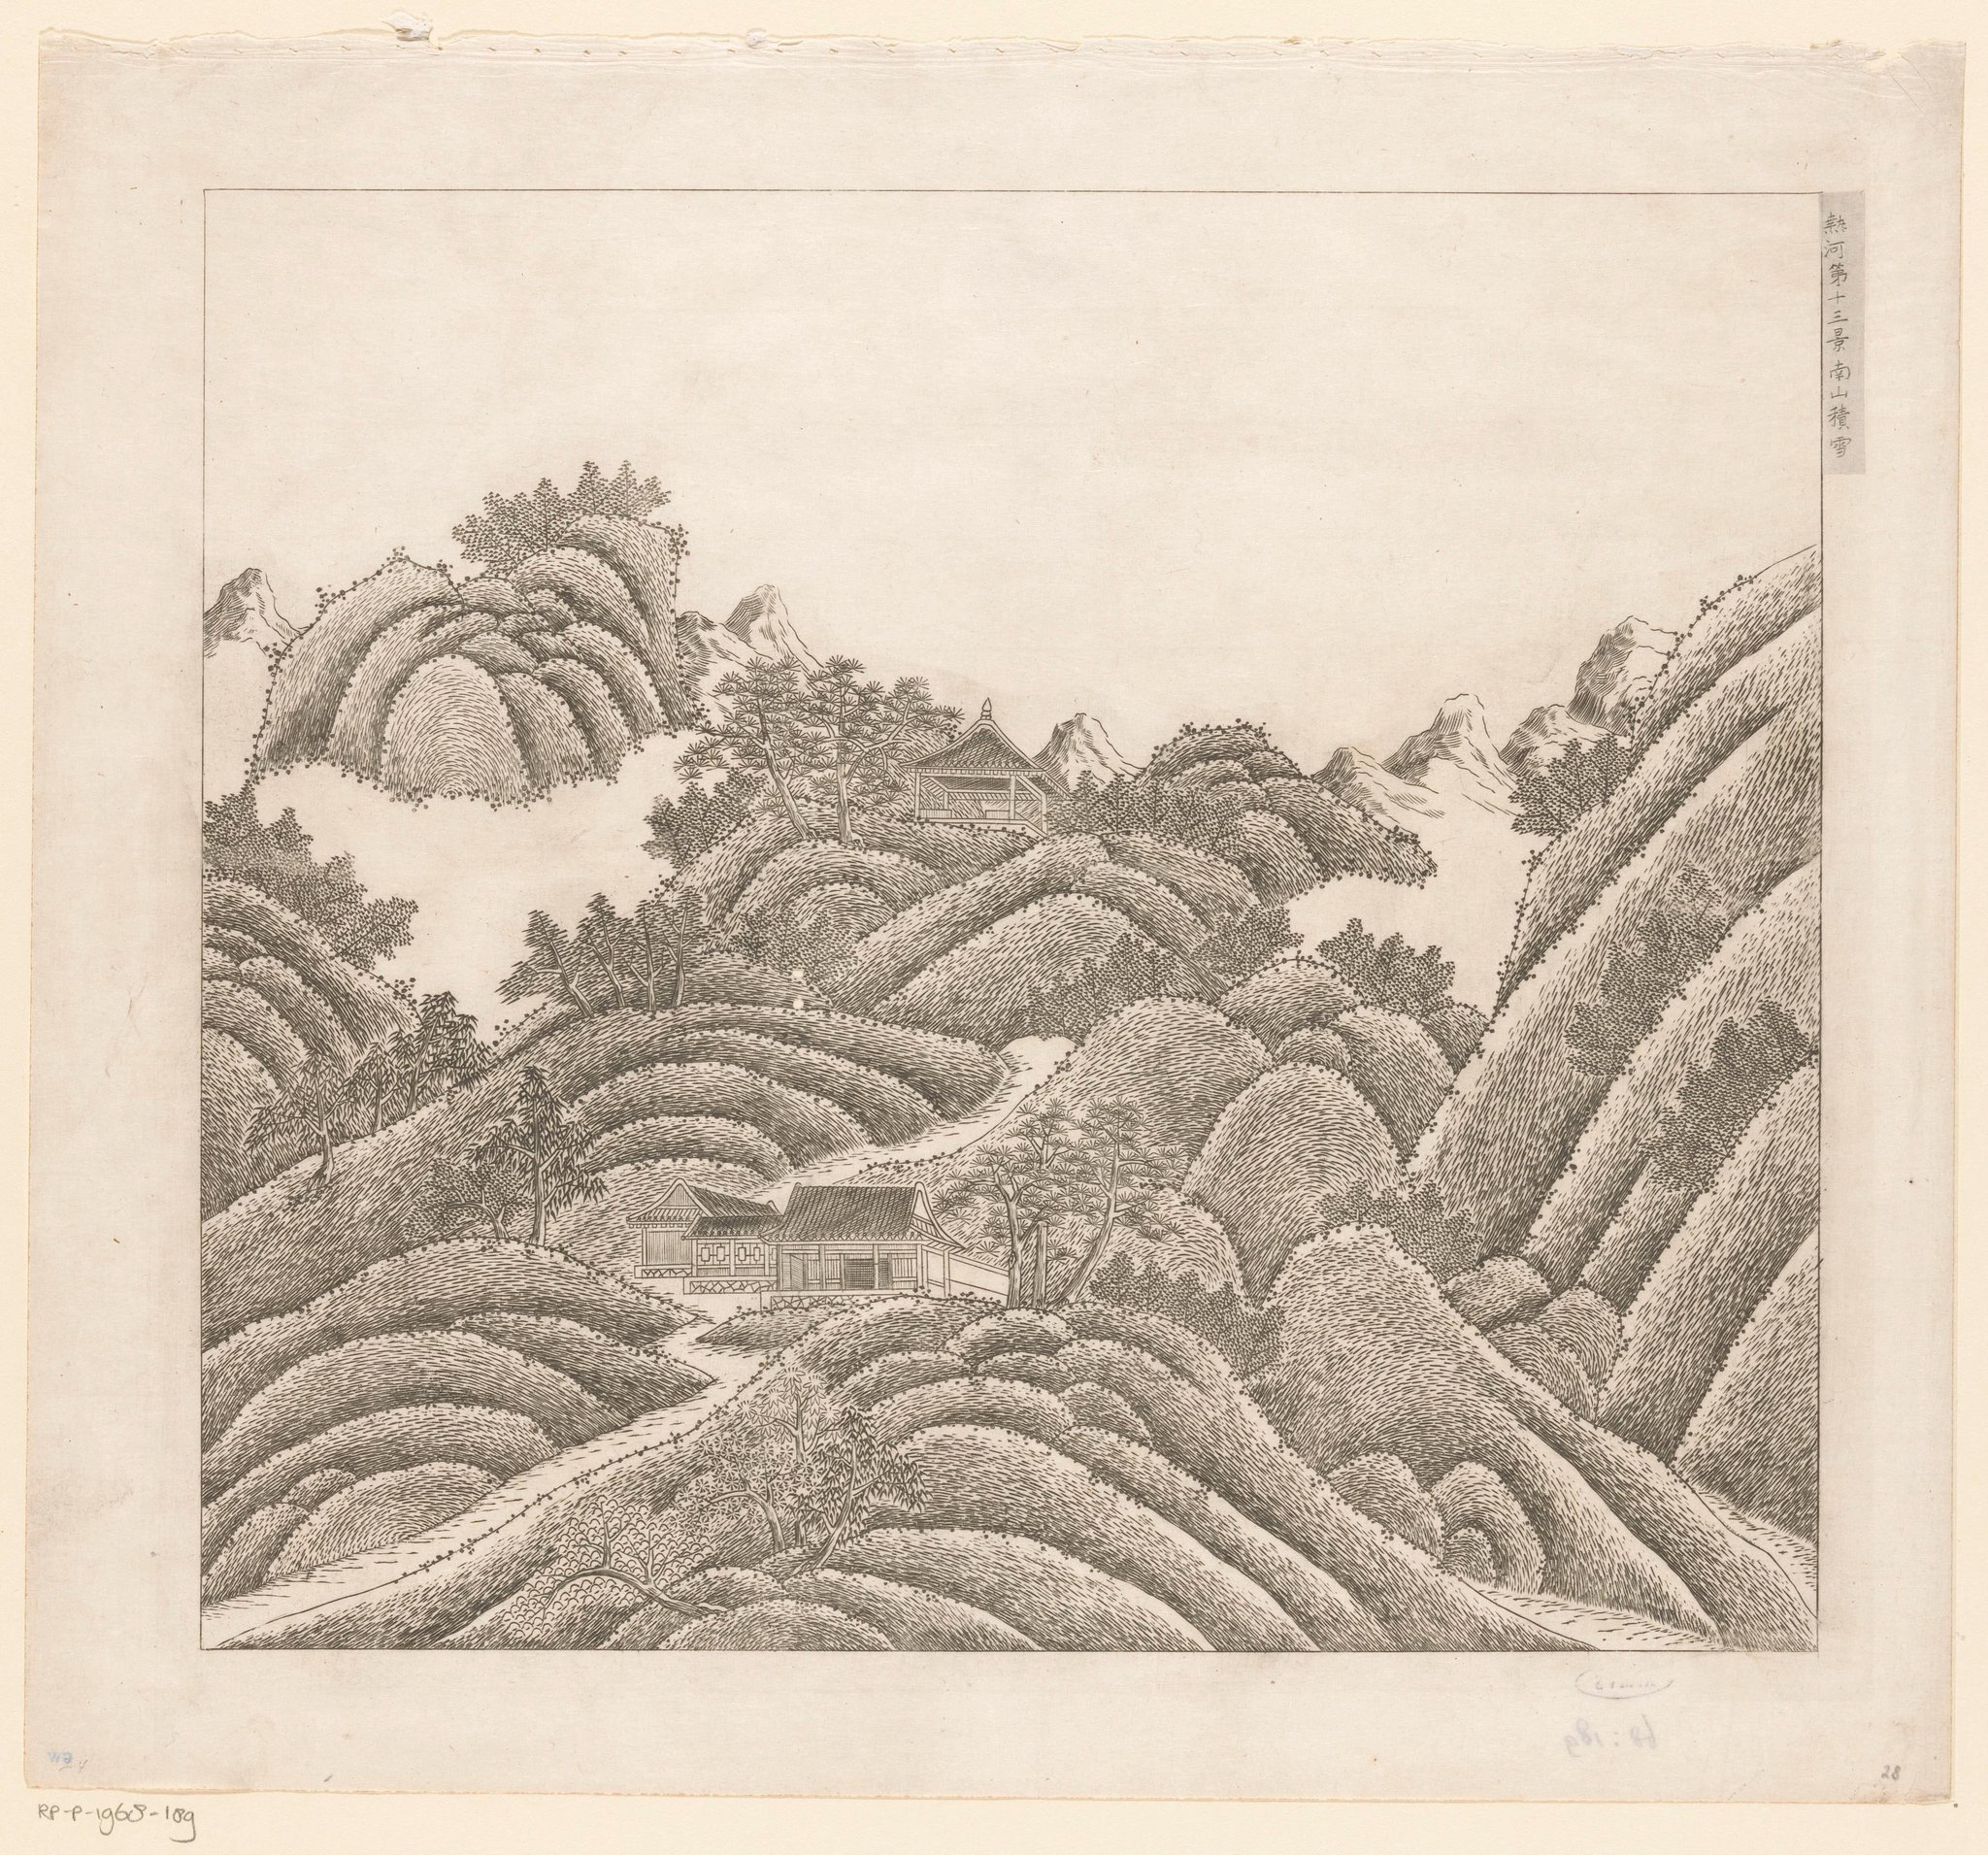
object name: print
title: Gezicht op een deel van het keizerlijk zomerpaleis in Chengde (Jehol) te China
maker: matteo ripa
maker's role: priest, print maker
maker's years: 1682-1746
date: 1712-1714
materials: paper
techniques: engraving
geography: china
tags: city-view, and landscape with man-made constructions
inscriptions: collector's mark: Lugt 2228, collector's mark: ‘GW’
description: Dertiende prent uit een serie van 36 prenten met gezichten op het keizerlijk zomerverblijf te Chengde (Jehol). De Italiaanse missionaris Matteo Ripa verbleef tussen 1711-1723 als kunstenaar aan hof van keizer Kangxi. Hij vervaardigde deze prentserie in samenwerking met enkele Chinese prentmakers. Uitgangspunt voor de ontwerpen van Shen Yu vormden de gedichten geschreven door keizer Kangxi. Het Rijksmuseum Amsterdam bezit 31 prenten van de serie. Twee andere prenten uit deze set worden bewaard in het British Museum (1968,0212,0.27 en 1968,0212,0.28).